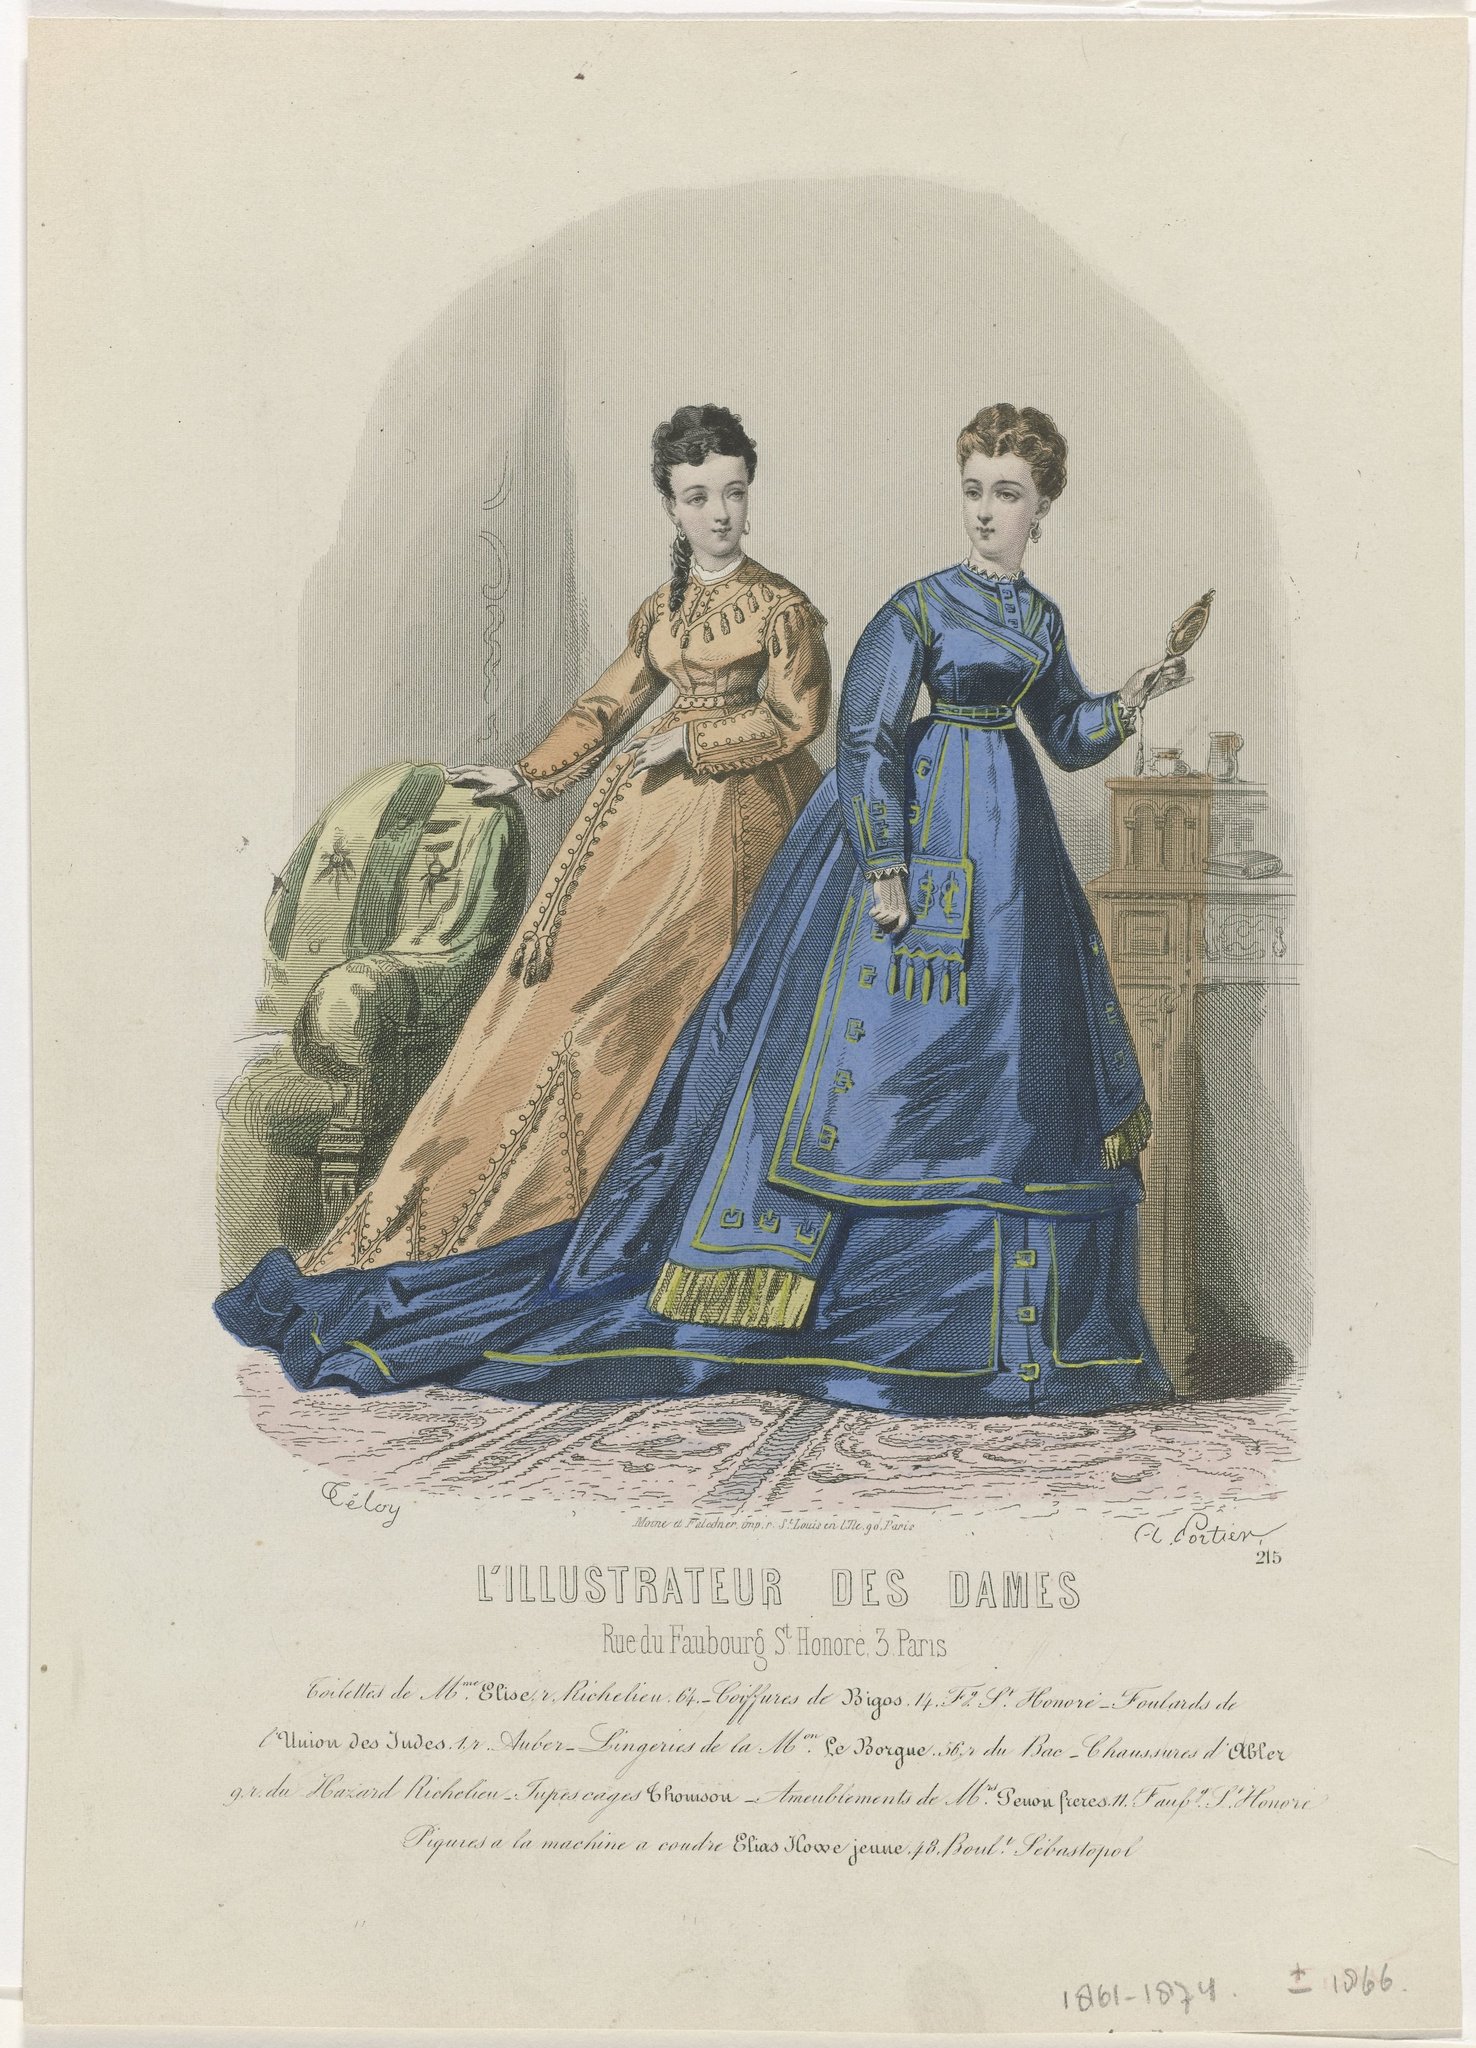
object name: fashion print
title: L'Illustrateur des Dames, ca. 1867, No. 215 : Toilettes de Mme Elis (...)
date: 1866-1867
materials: paper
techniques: engraving, hand coloring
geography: paris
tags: ear-rings (+ women's clothes), armchair, seat, styles of hairdress - aa - ~ women, fashion plates, gloves, mittens, etc. (+ women's clothes)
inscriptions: title: ‘L'Illustrateur des Dames’, address: ‘Rue du Faubourg St Honore 3 Paris’, caption: ‘Toilettes de M.me Elise. r. Richelieu. 64 _ Coiffures de Bigos. 14. Fg Honoré _ Foulards de l'Union des Indes, 1 r. Auber _ Lingeries de la M.on le Borgue. 56, r du Bac _ Chaussures d'Abler g. . du Hazard Richelieu _ Jupes cages Thomson _ Ameublements de M.rs Penou freres.11. Faub.g S.t Honore Piqures a la machine a coudre Elias Howe jeune, 48, Boul.t Sébastopol.’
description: Twee vrouwen in een interieur. Volgens het onderschrift: ensembles van Elise. 'Coiffures'(kapsels) door Bigos. Hieronder enkele regels reclametekst voor verschillende producten. Prent uit het modetijdschrift L'Illustrateur des Dames (1861-1874).